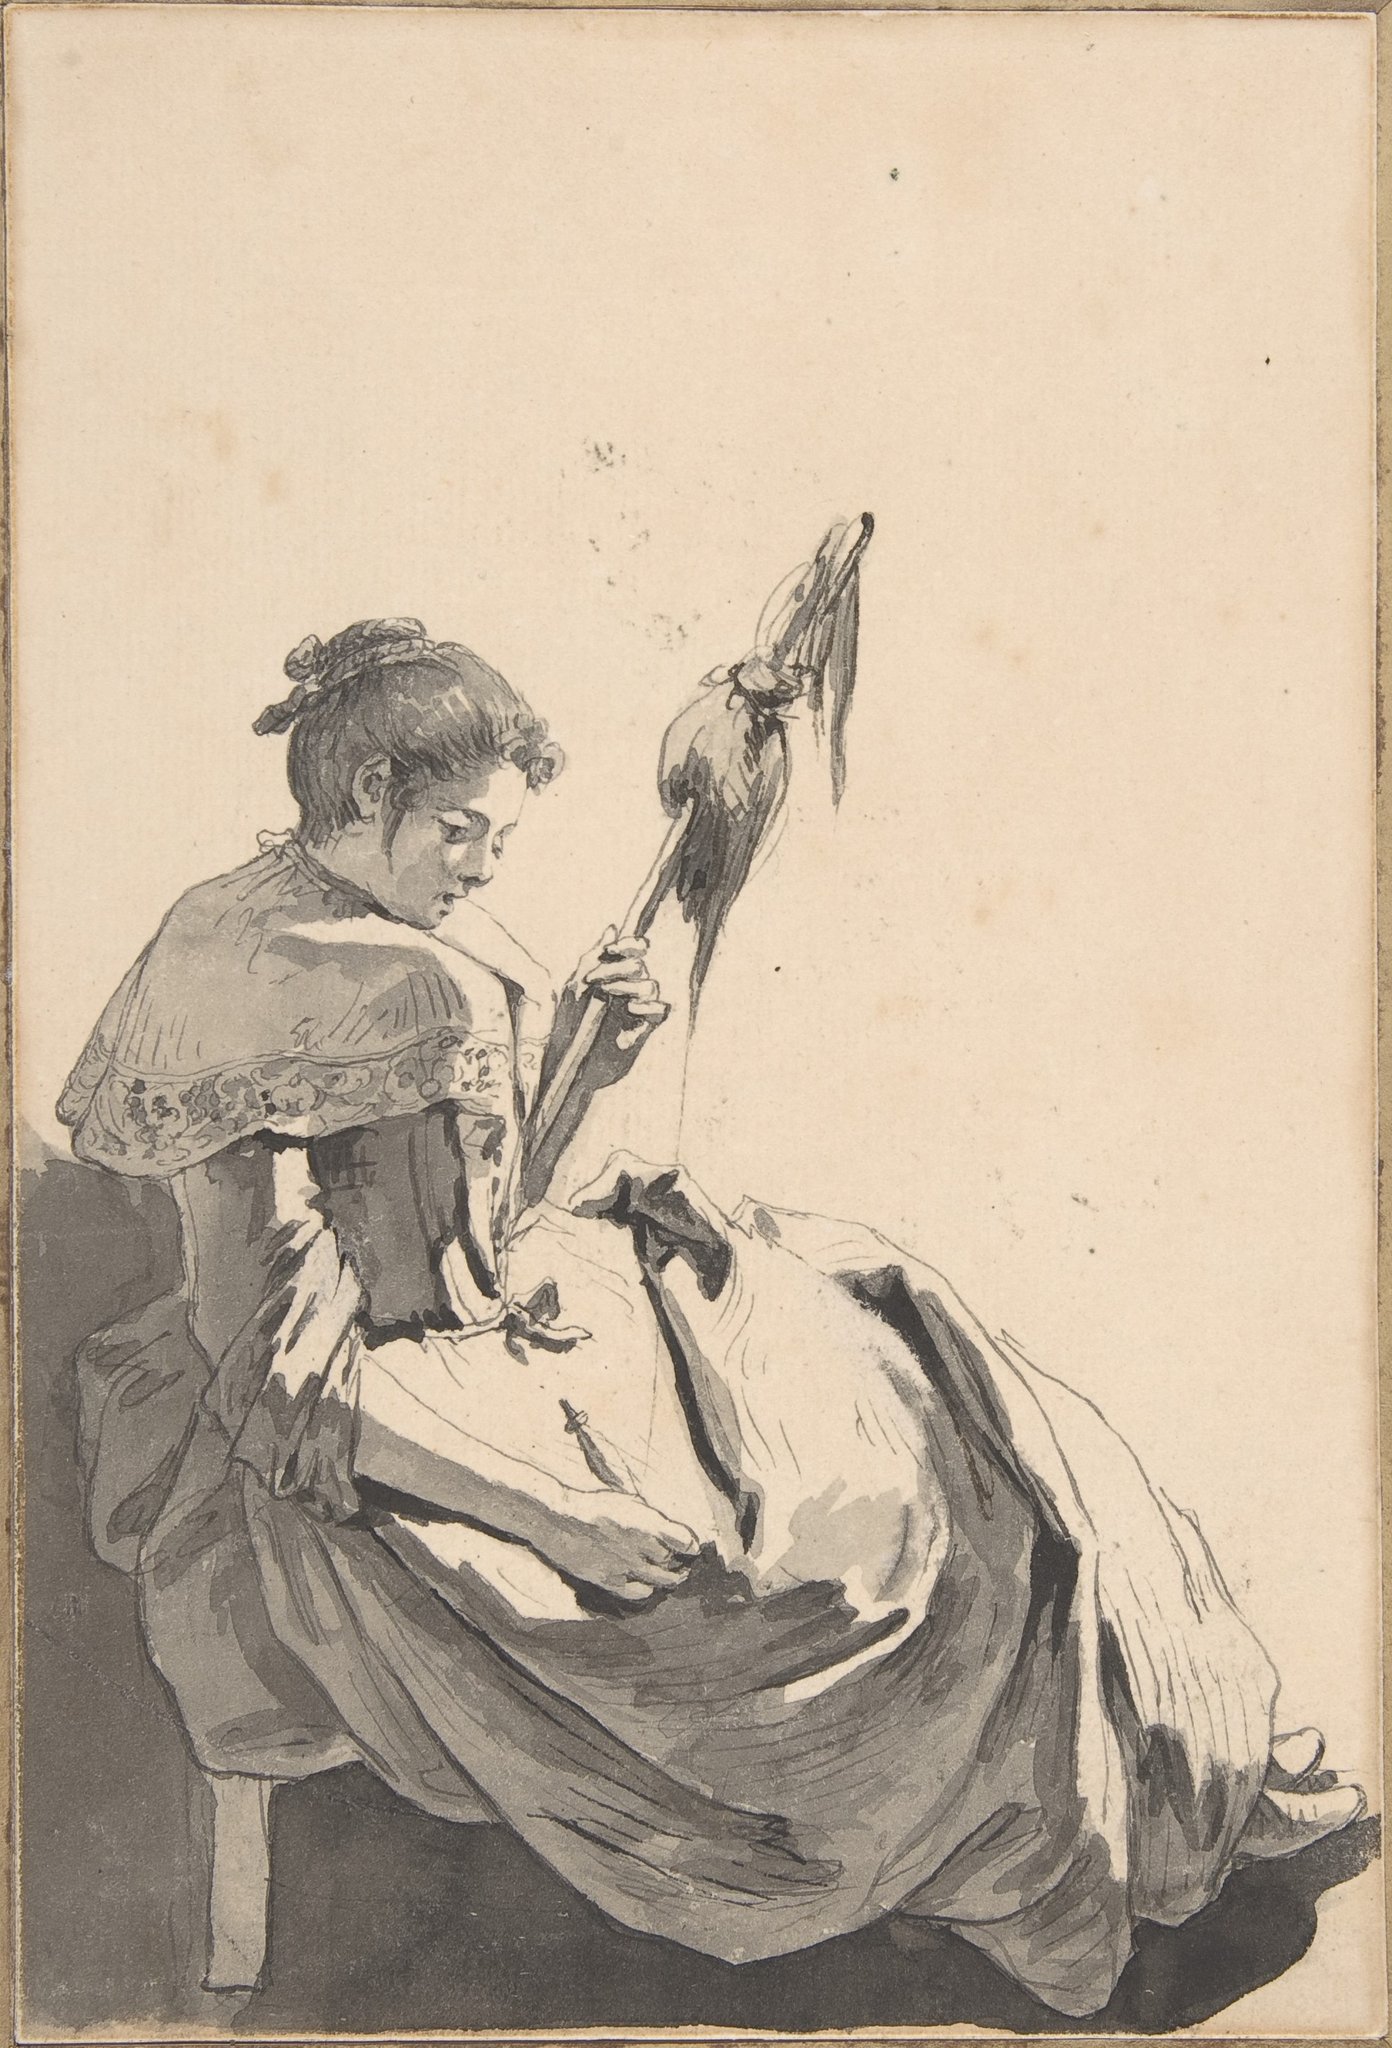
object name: drawing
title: Bolognese Peasant Girl with a Distaff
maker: jean-baptiste greuze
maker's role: artist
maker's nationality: french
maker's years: 1725-1805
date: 1755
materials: graphite, ink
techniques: brush, pen, wash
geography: france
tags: girls